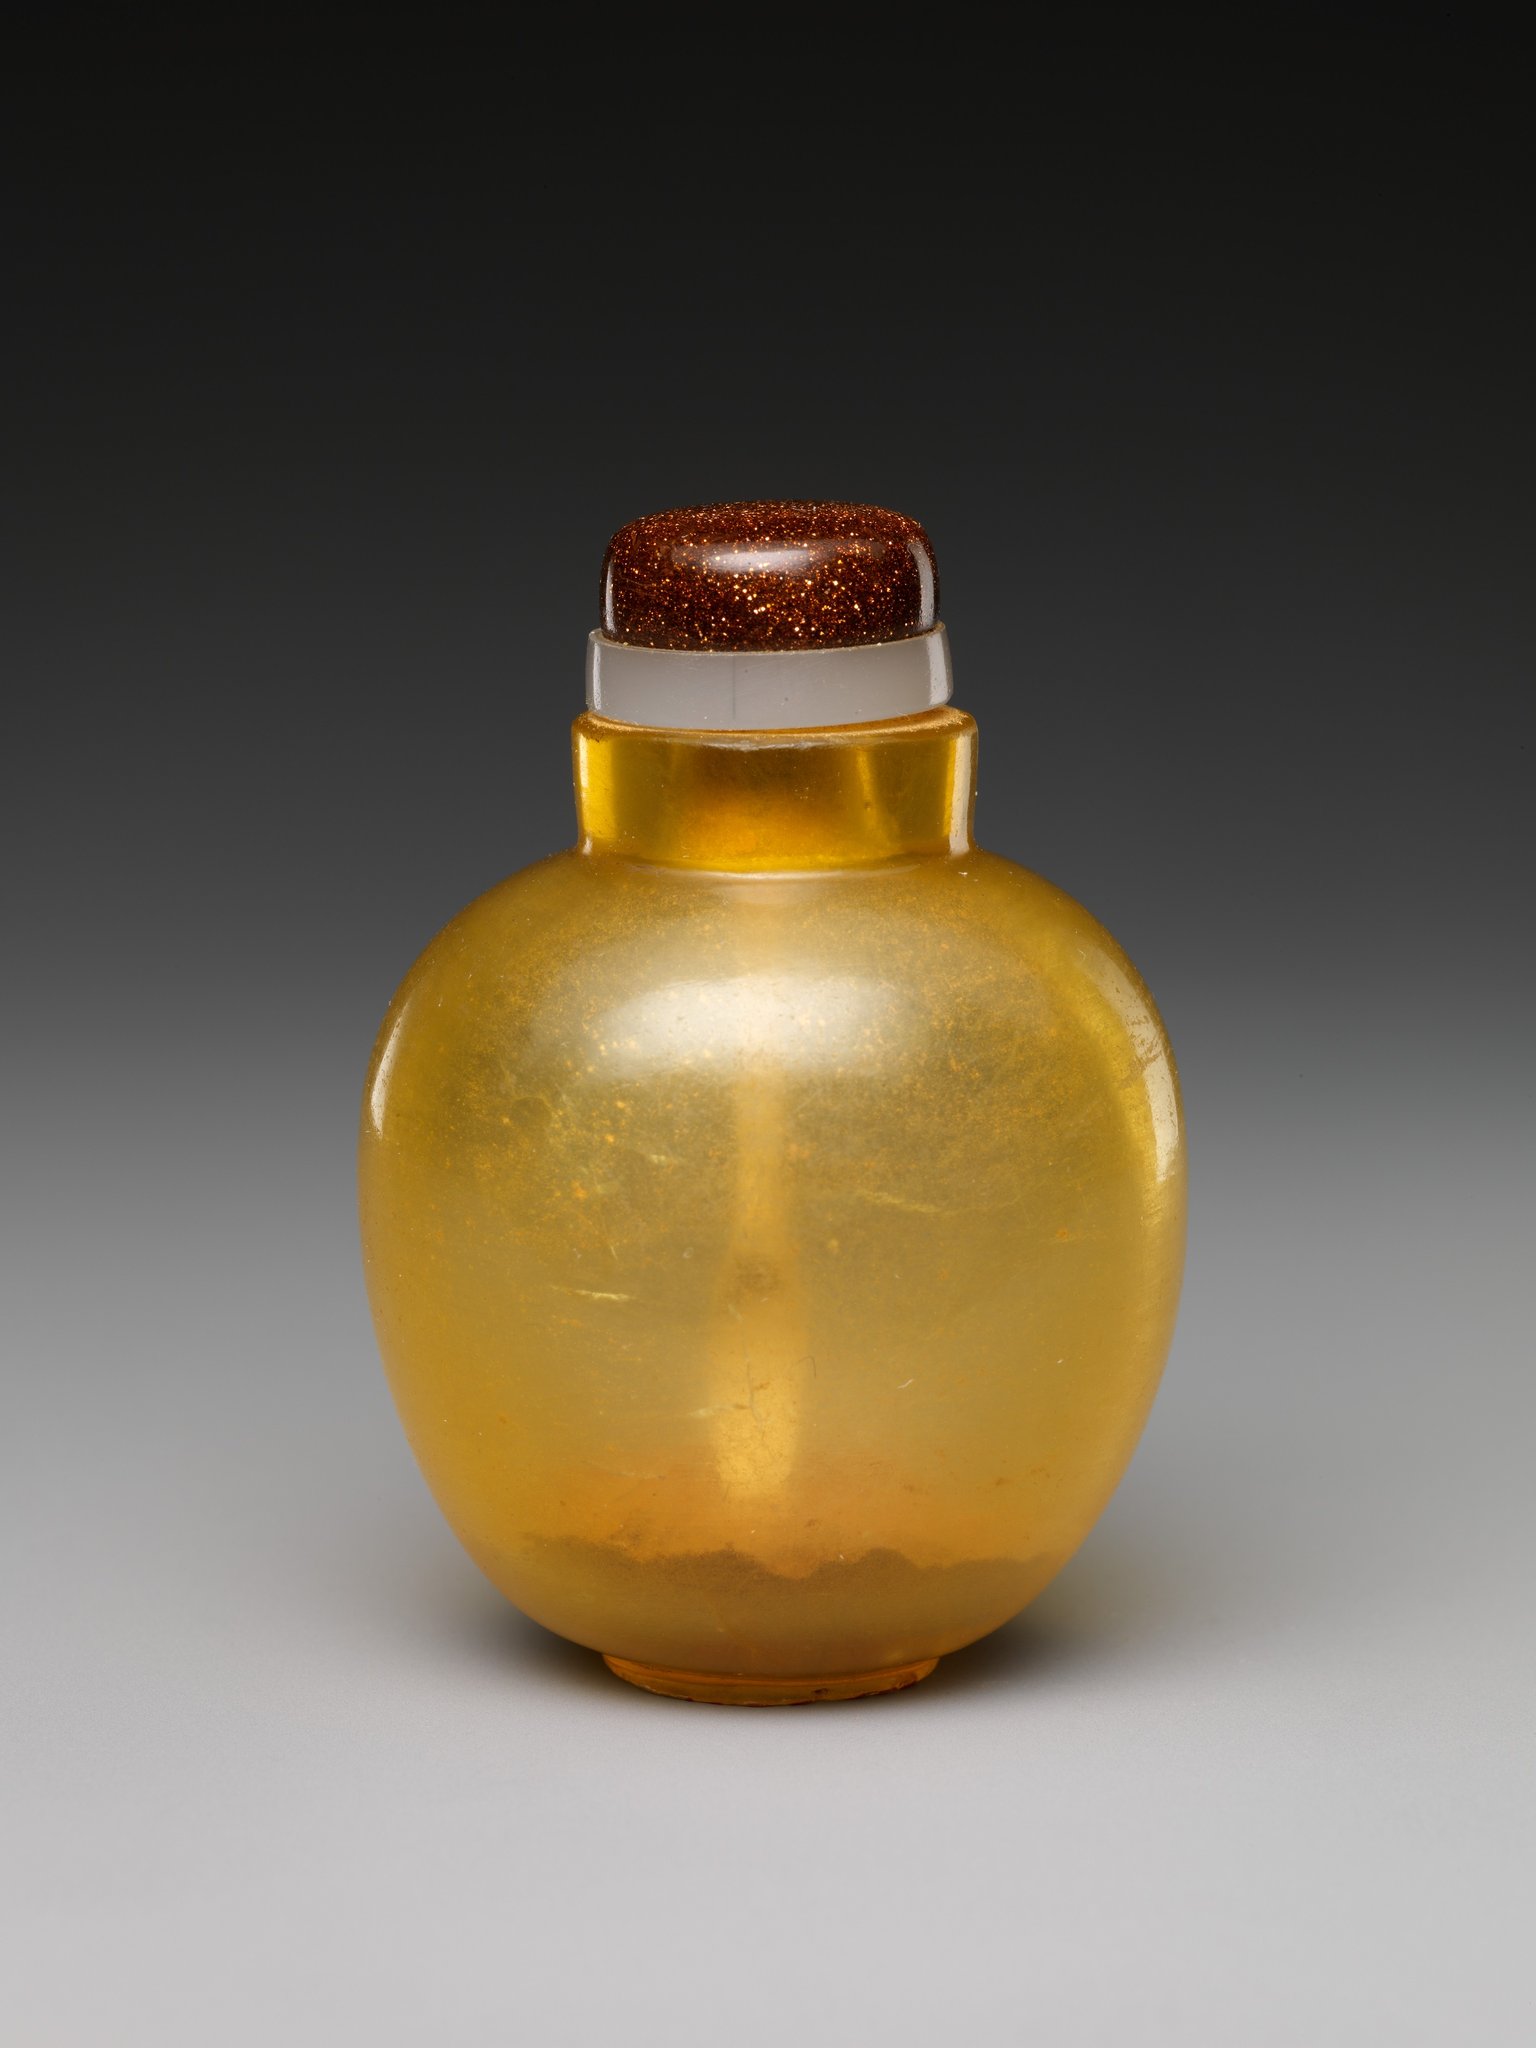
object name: snuff bottle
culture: chinese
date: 1701-1900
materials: glass